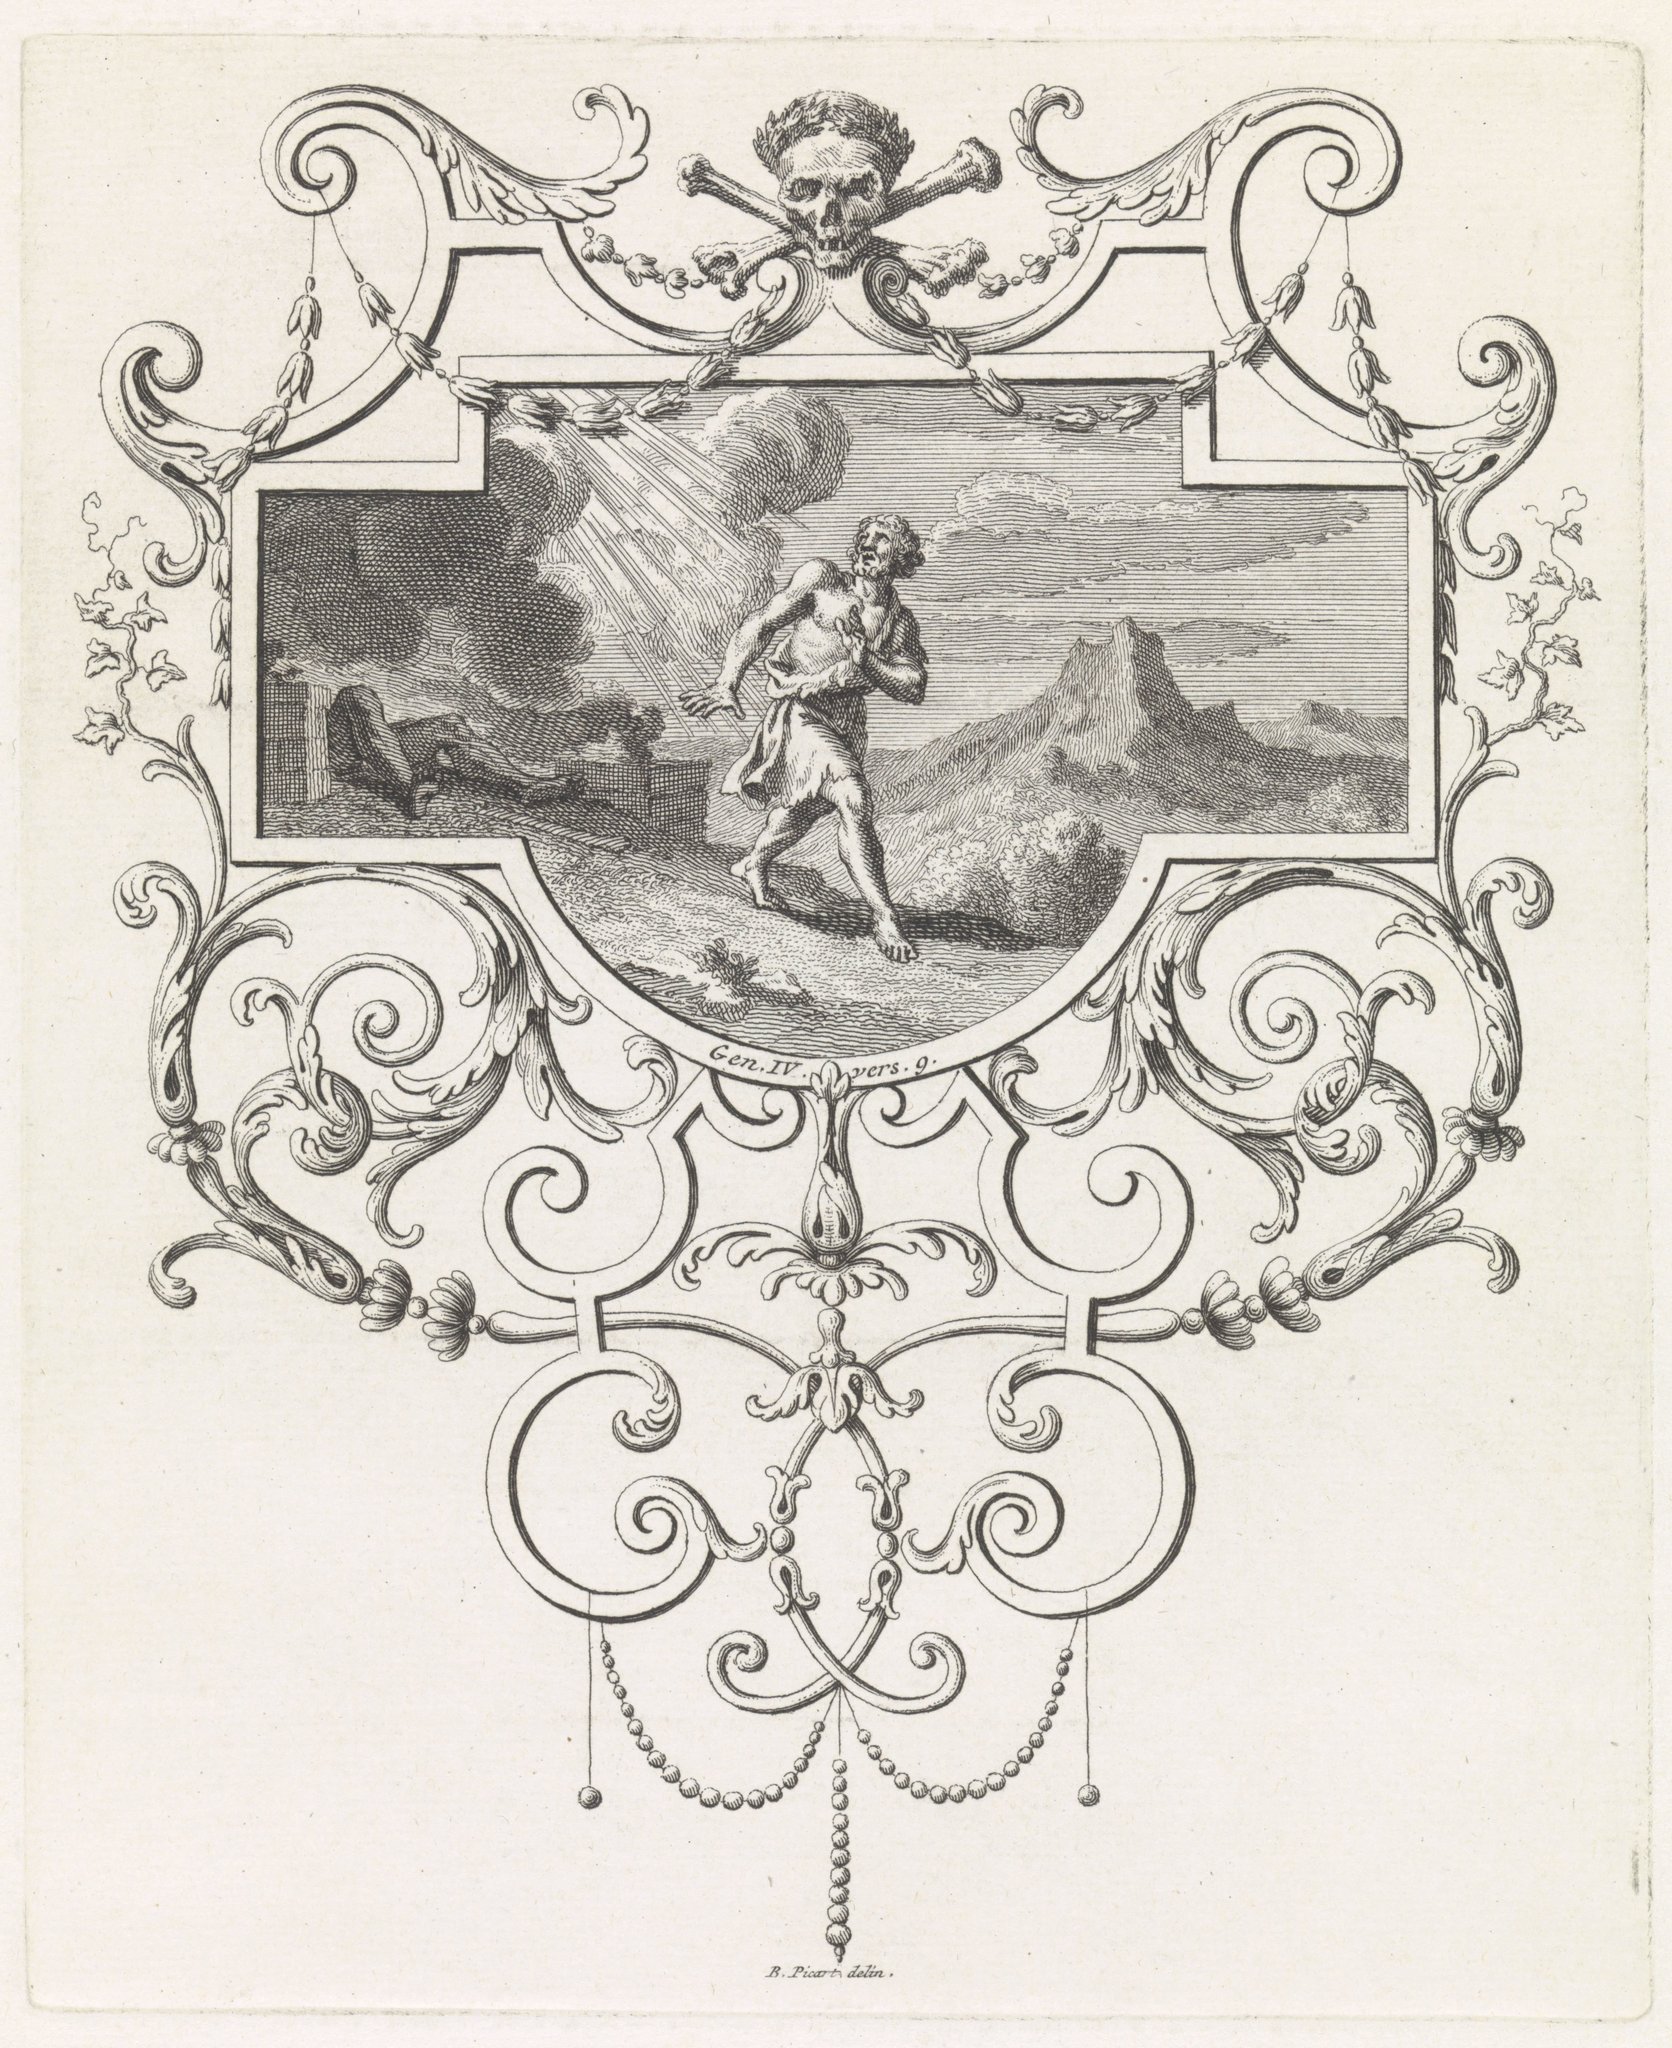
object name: ornament print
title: Kaïn door God aangesproken na de moord op Abel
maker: bernard picart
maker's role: draughtsman, print maker, publisher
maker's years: 1673-1733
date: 1683-1733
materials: paper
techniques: engraving, etching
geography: amsterdam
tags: ornament ~ festoon, garland, foliage, tendrils, branches ~ ornament, the lord calls on cain to account for his deed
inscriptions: collector's mark: Lugt 2233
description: Prent oorspronkelijk bedoeld voor: Figures de la Bible. Amsterdam, Bernard Picart, 1720. Prent ook gebruikt in: Taferelen der voornaamste geschiedenissen van het Oude en Nieuwe Testament (...) door de vermaarde kunstenaars Hoet, Houbraken, en Picart getekent (...) en met beschrijvingen uitgebreid. Den Haag: Pieter de Hondt, 1728. Prent kan mogelijk ook zijn gebruikt in andere bijbels.